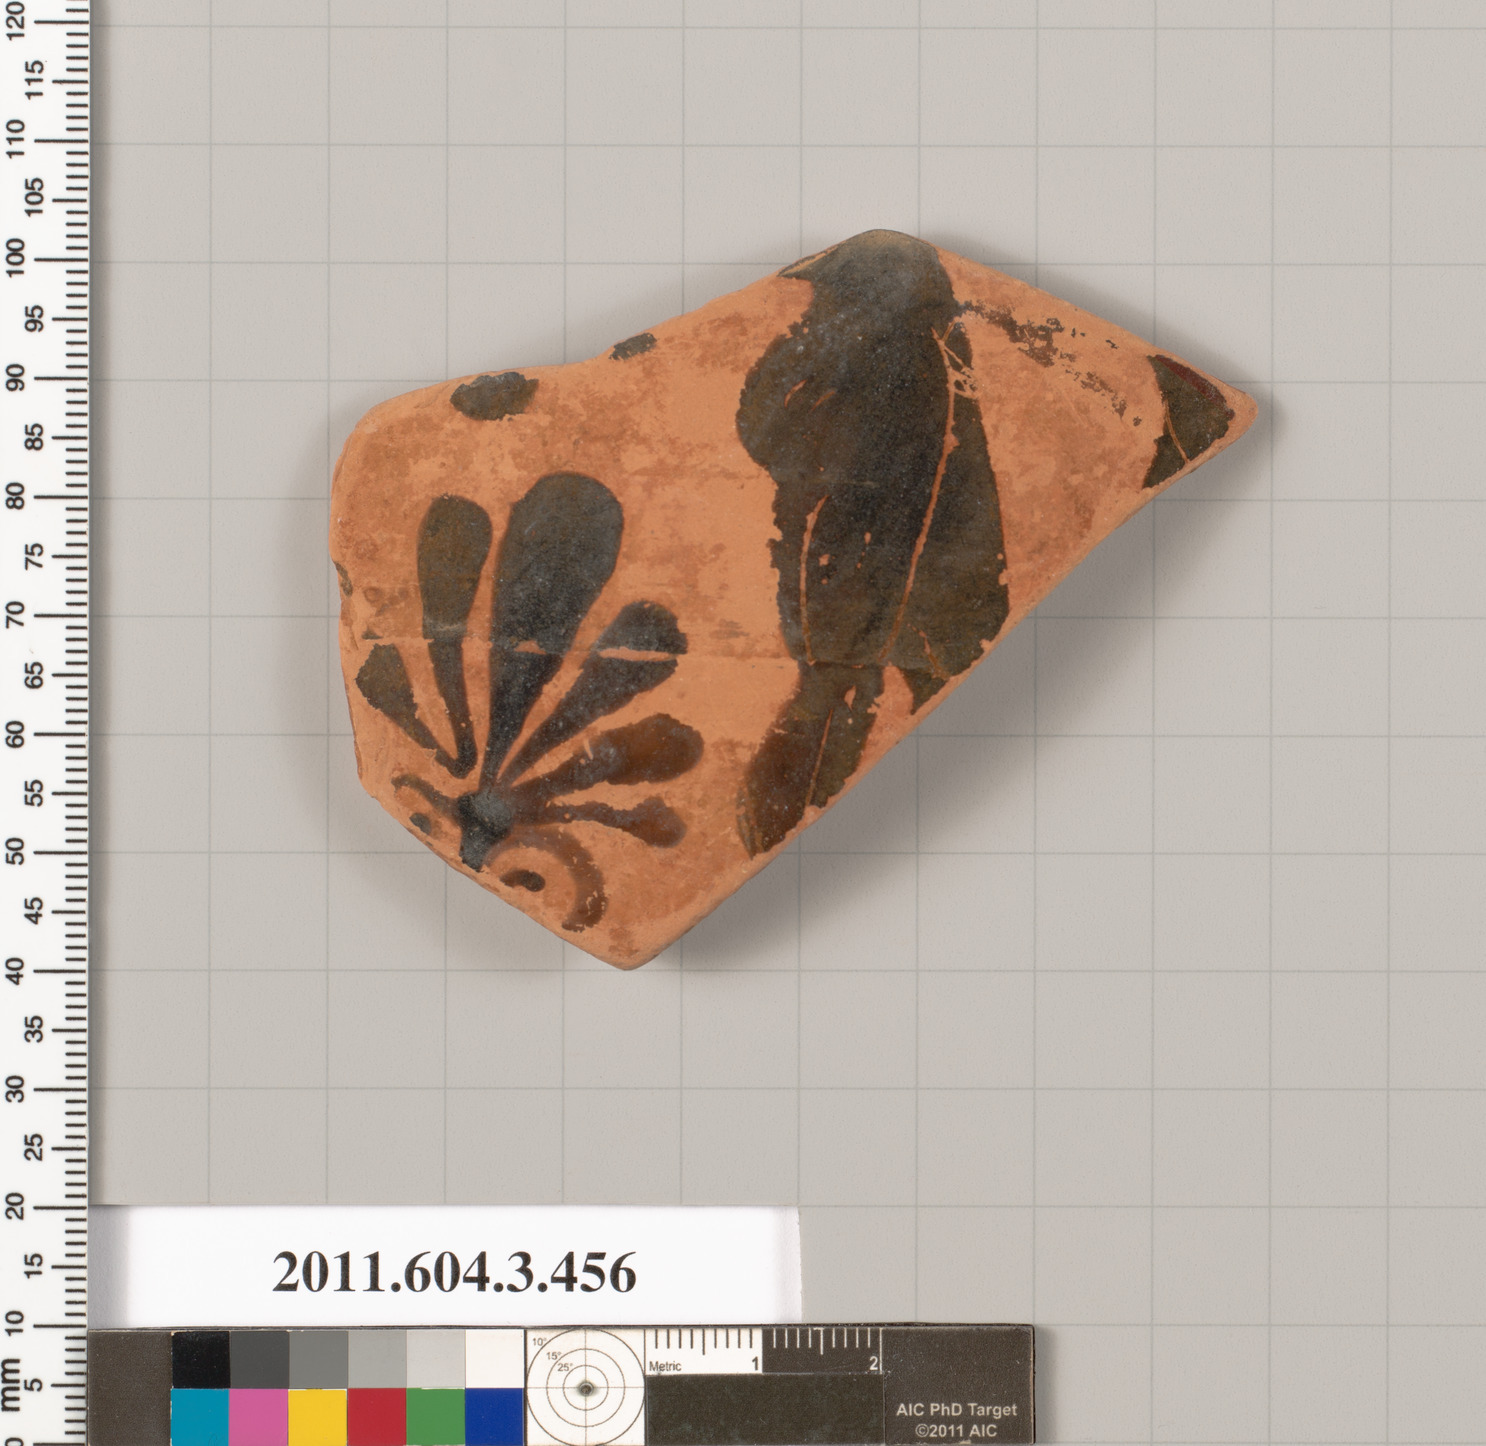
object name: neck amphora fragment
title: Terracotta fragment of a neck-amphora (jar)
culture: greek, attic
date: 490-480 BCE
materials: terracotta